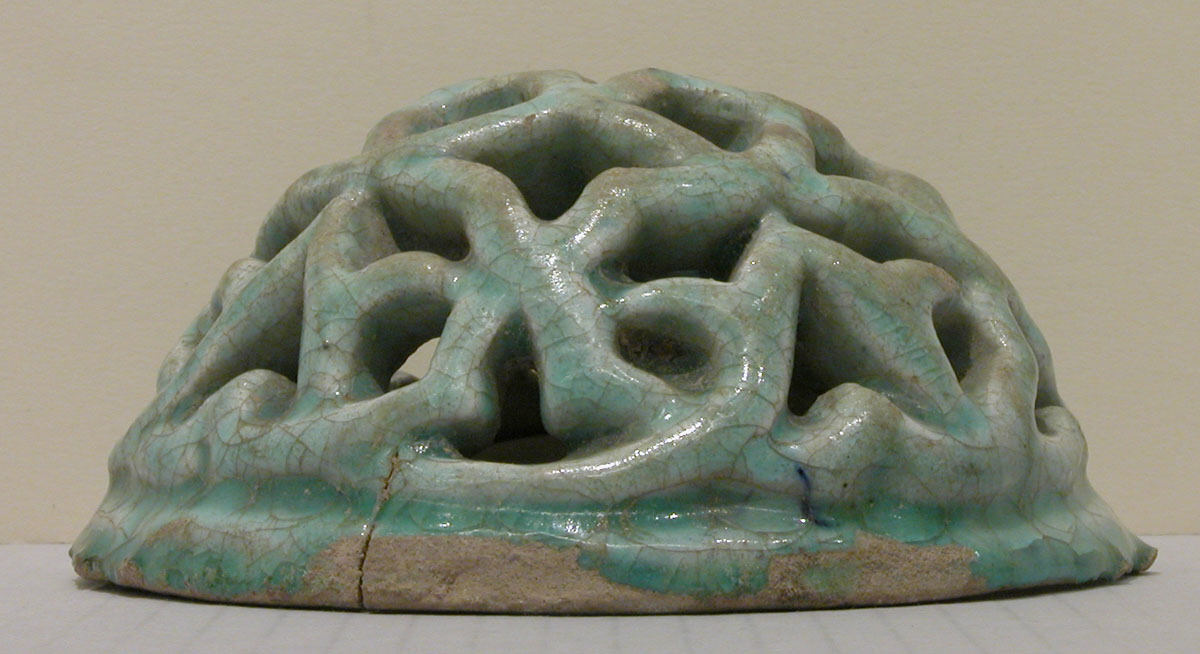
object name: bos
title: Architectural Boss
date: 1201-1300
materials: stonepaste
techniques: carving, glazing, molding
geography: turkey